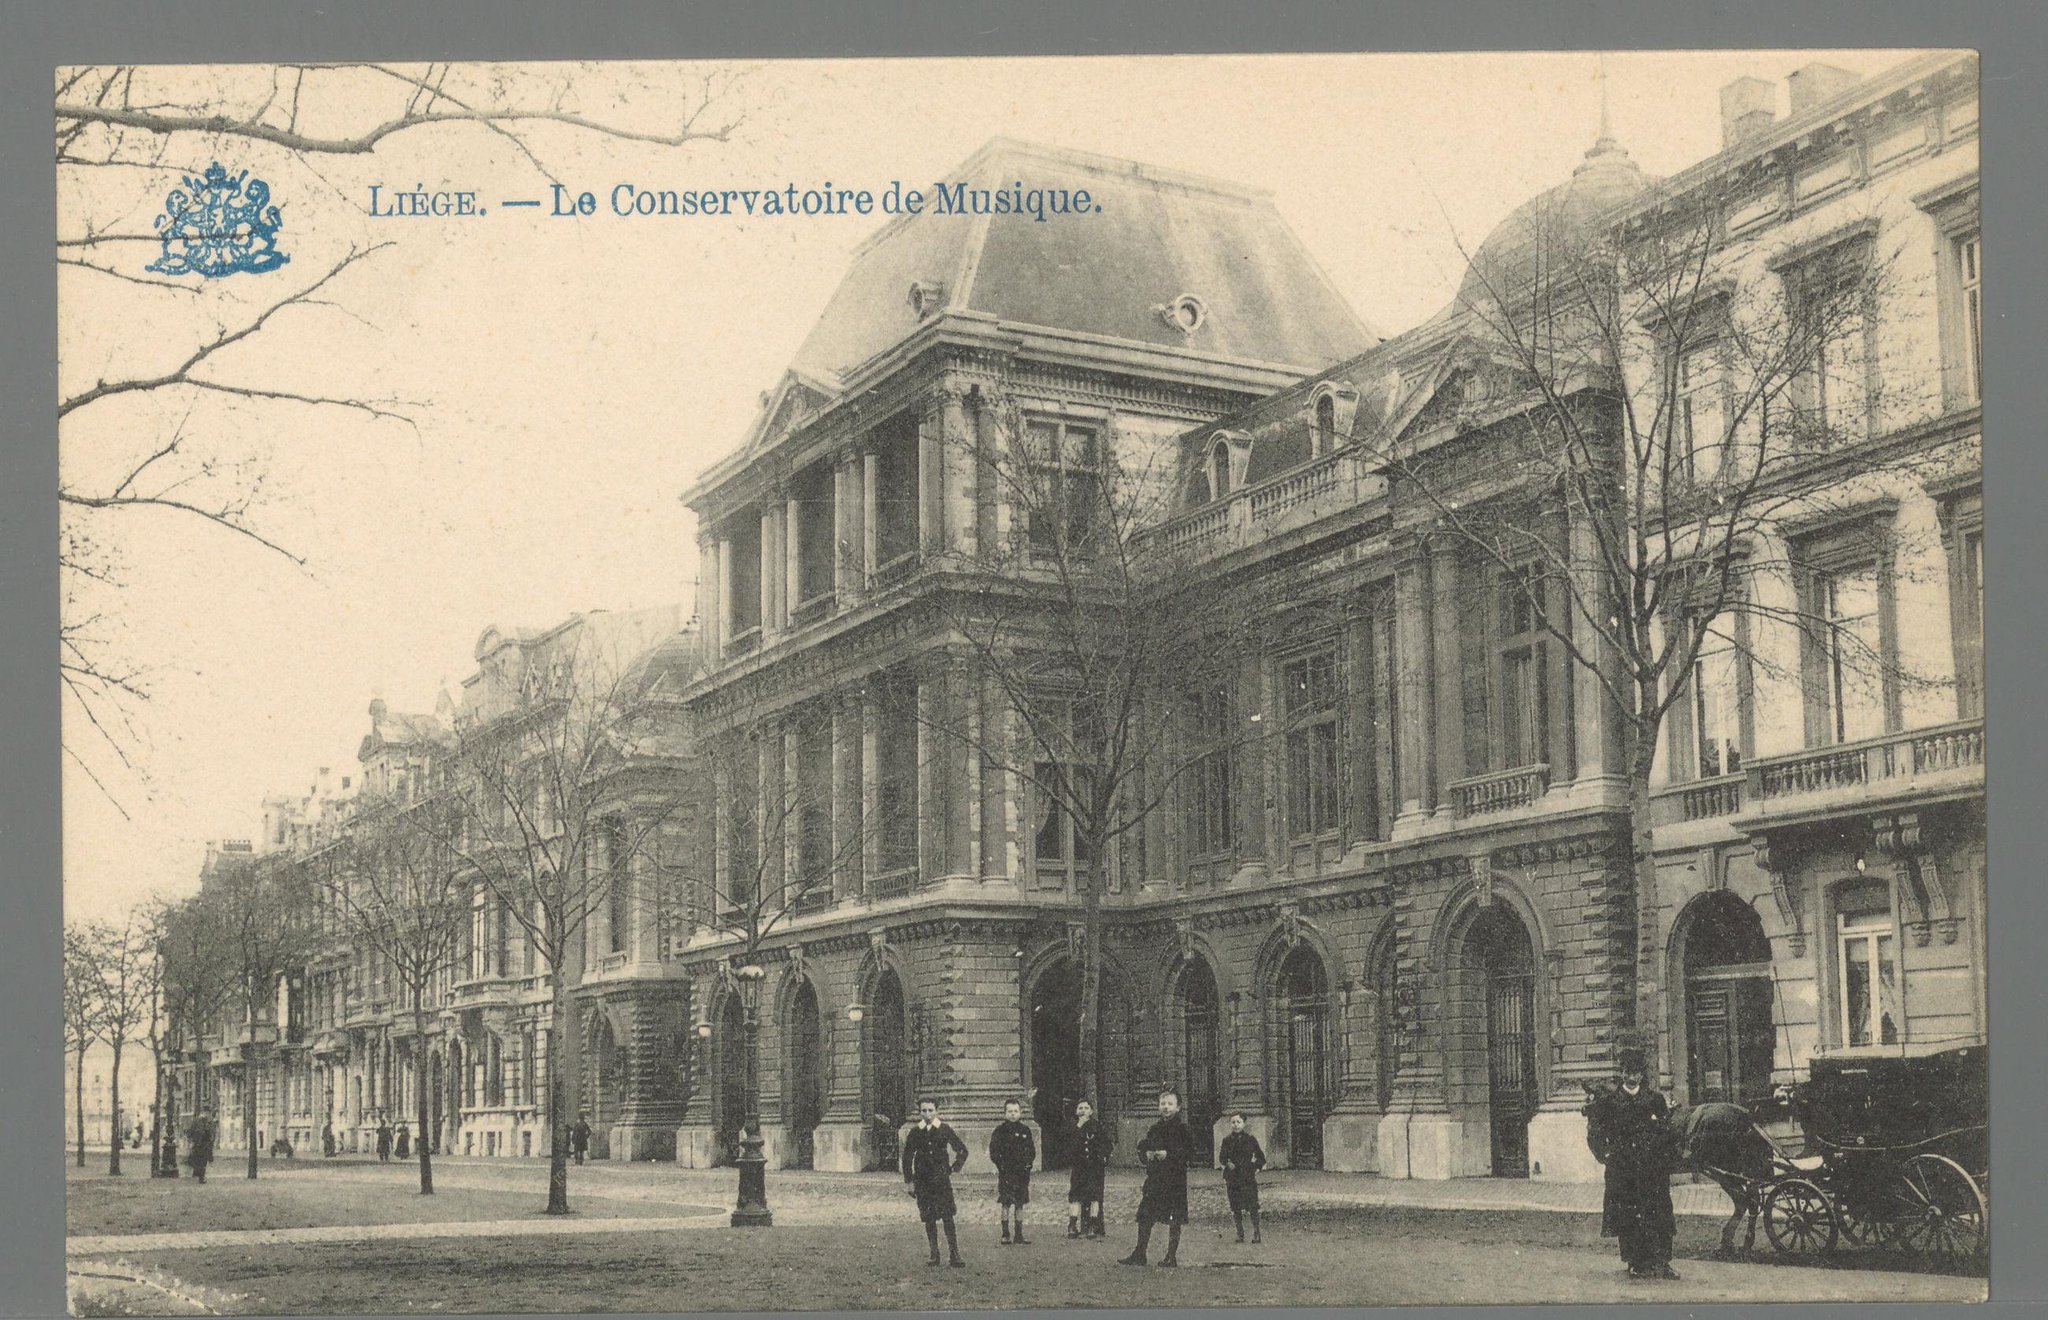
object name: photomechanical print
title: Liège. Le Conservatoire de Musique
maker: Anonymous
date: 1892-1906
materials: cardboard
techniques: photograph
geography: liège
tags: further education (+ building ~ education, tuition), music, city-view, and landscape with man-made constructions (+ city(-scape) with figures, staffage), liège